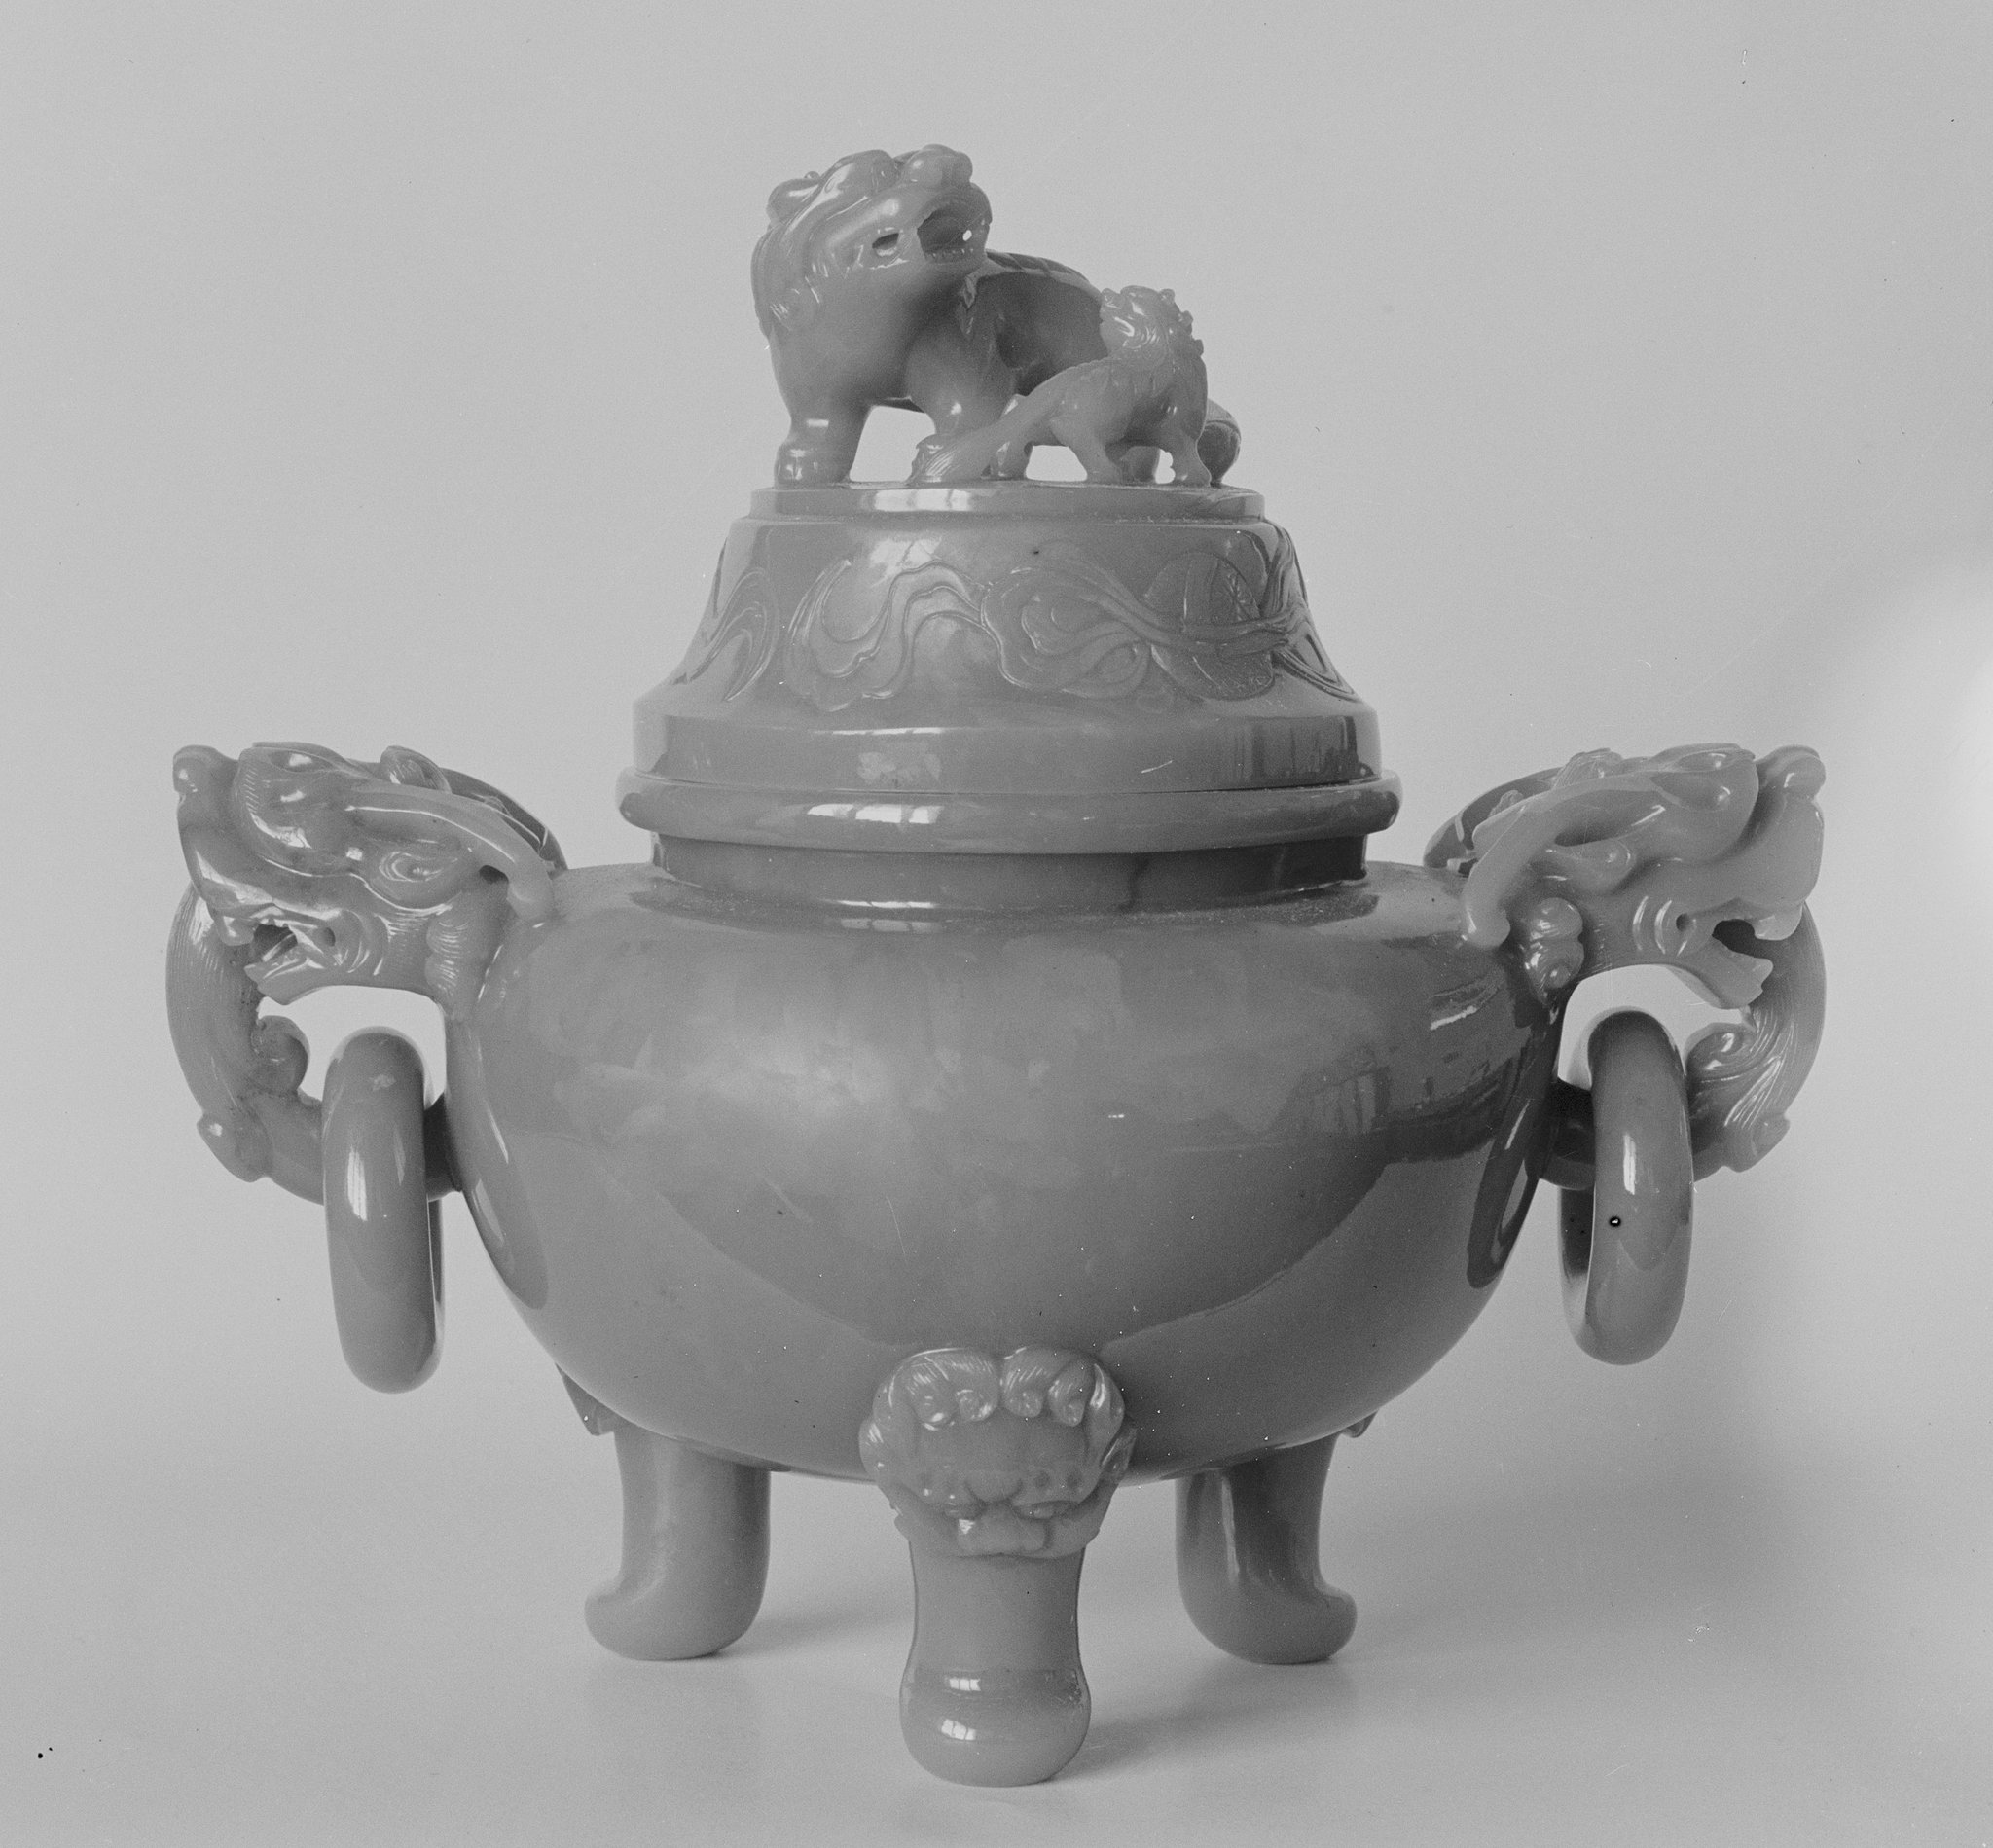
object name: covered incense burner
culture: chinese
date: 1736-1795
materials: jade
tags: animals